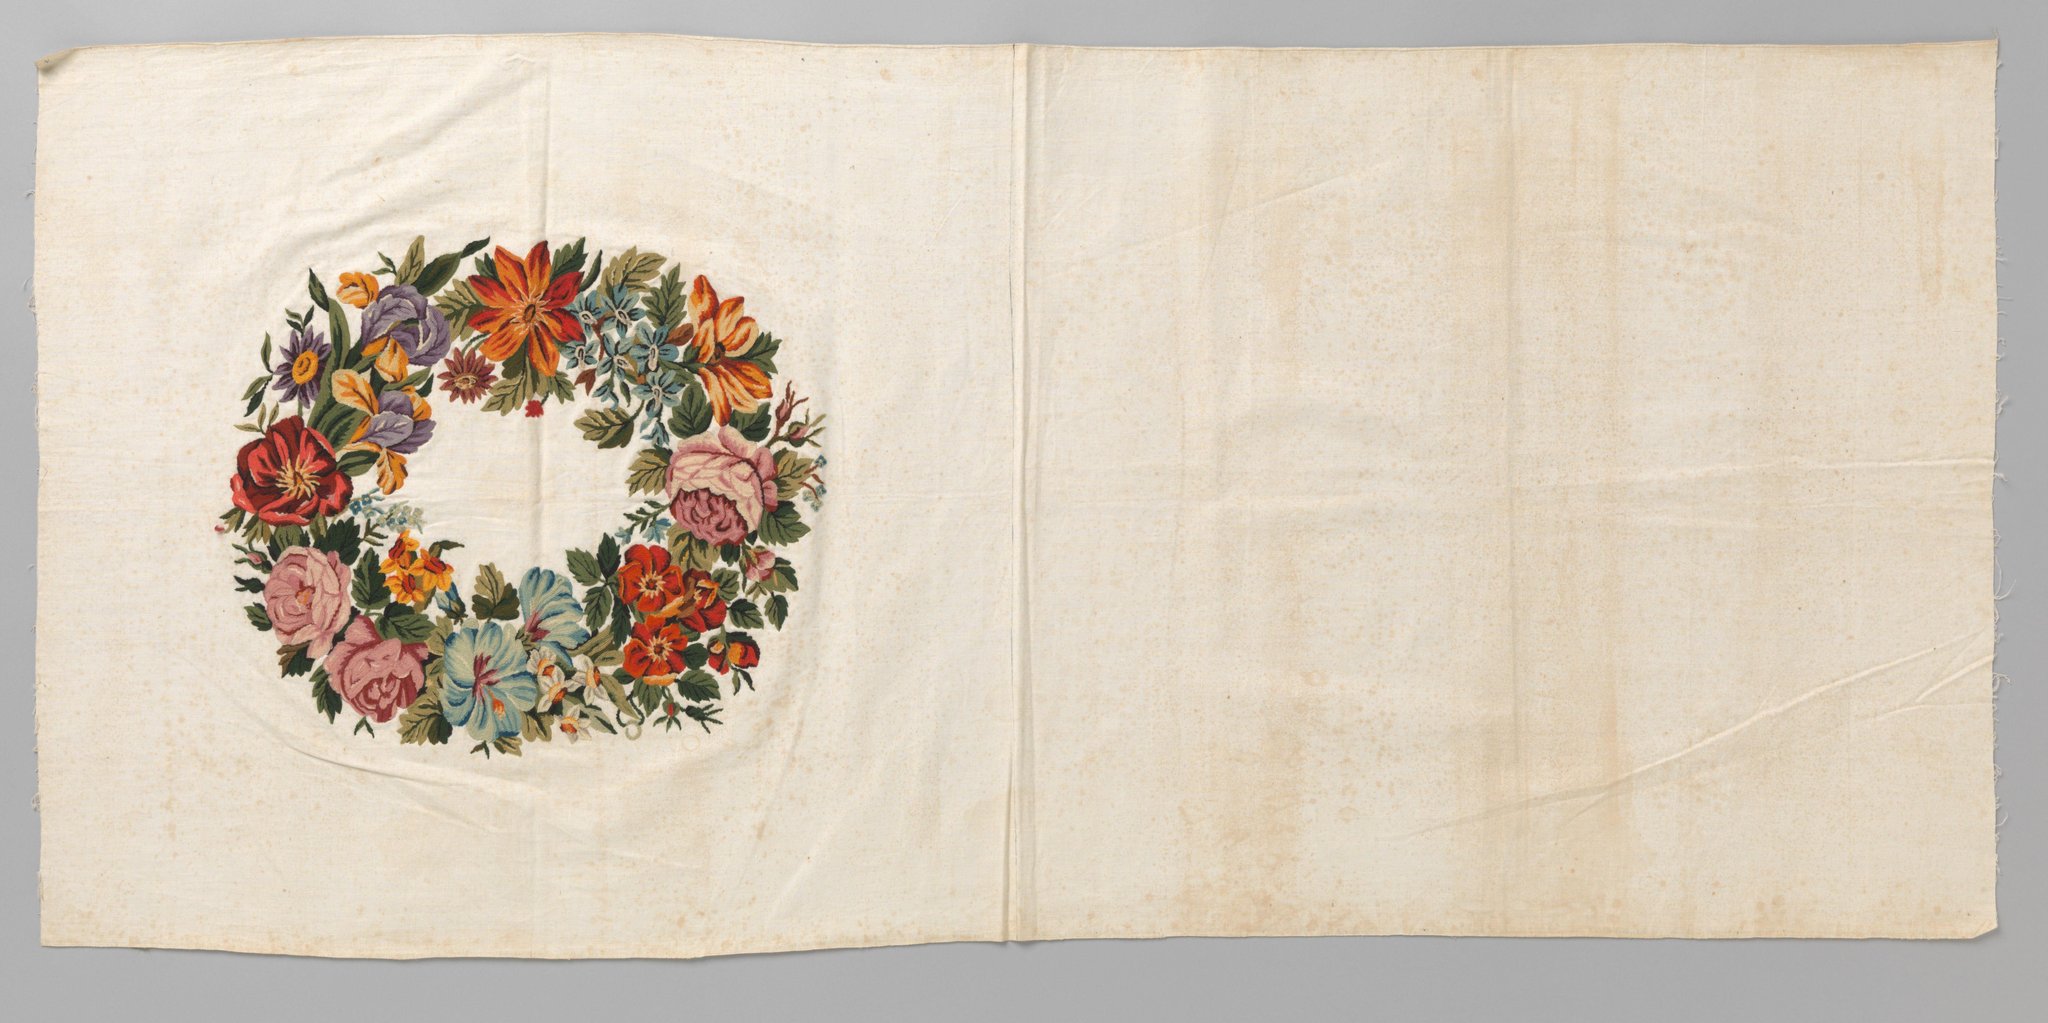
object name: bekledingsstof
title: Metrage bekledingsstof met borduurwerk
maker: Anonymous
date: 1850-1949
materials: cotton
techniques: weave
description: Metrage bekledingsstof, geborduurd met kleurige bloemenkransen in kettingsteek.